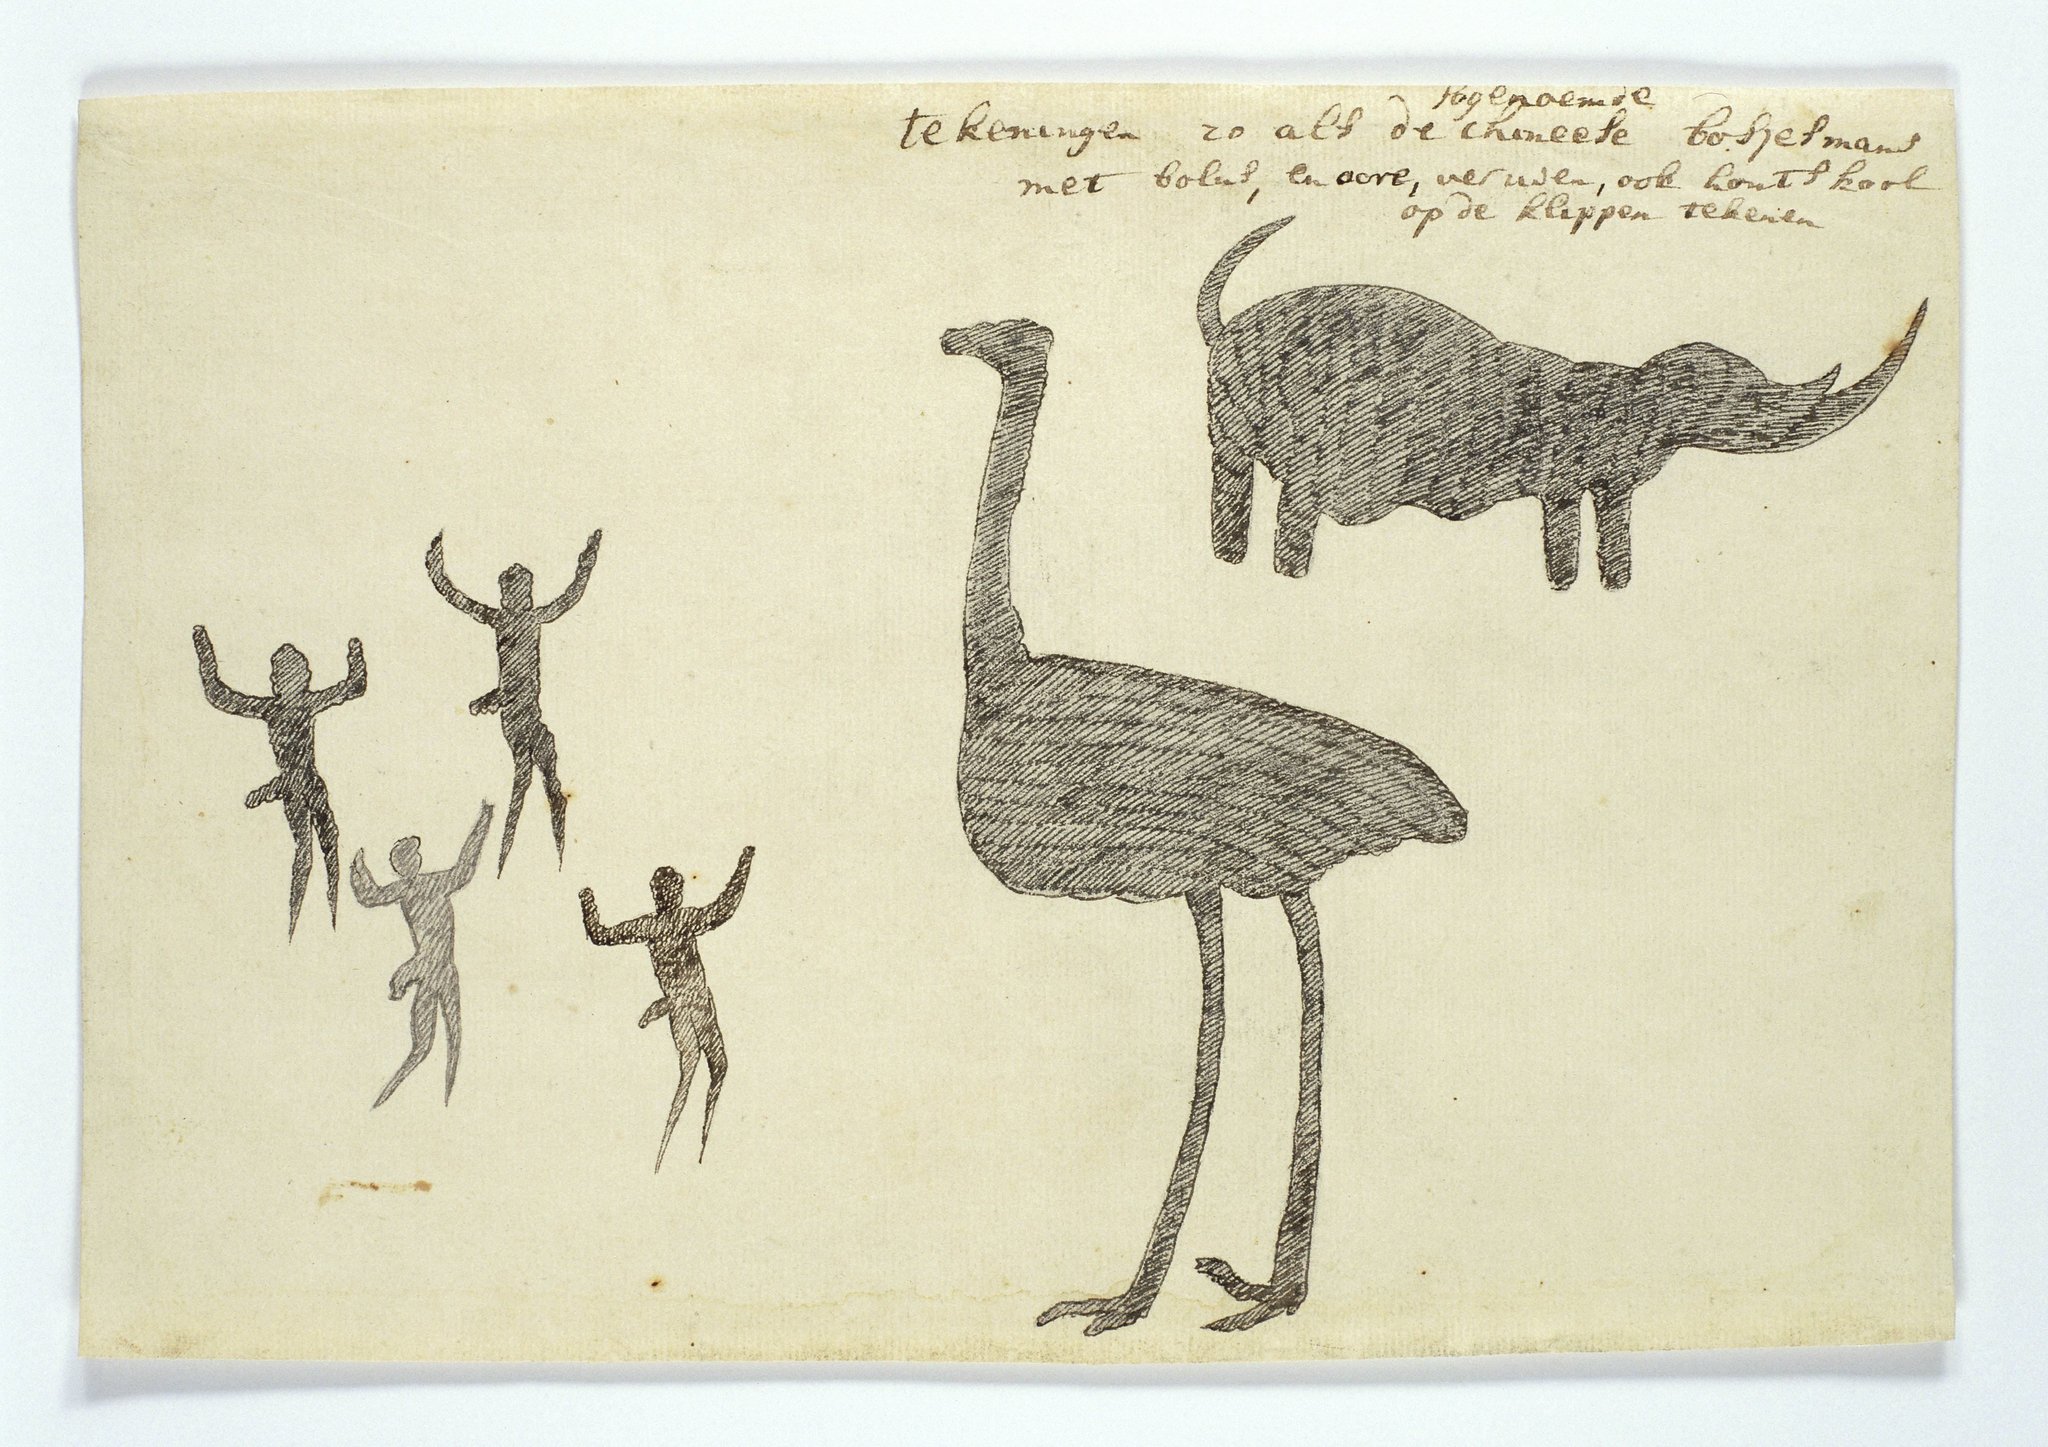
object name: drawing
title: Copies after San rock-paintings of an ostrich, a rhinoceros, and four figures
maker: robert jacob gordon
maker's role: draughtsman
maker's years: 1743-1795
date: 1777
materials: ink, paper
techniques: brush, pen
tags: zuid-afrika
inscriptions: annotation: ‘tekeningen zo als de sogenoemde (boven de regel ingevoegd) chineese bosjesmans / met bolus, en acre, verwen, ook houtskool / op de klippen tekenen’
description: Een neushoorn en een struisvogel, met vier achteruitdeinzende figuurtjes met opgeheven armen. Rotstekening van de San, die met kleurstoffen, houtskool en natuurlijke materialen op de rotsen schilderden.